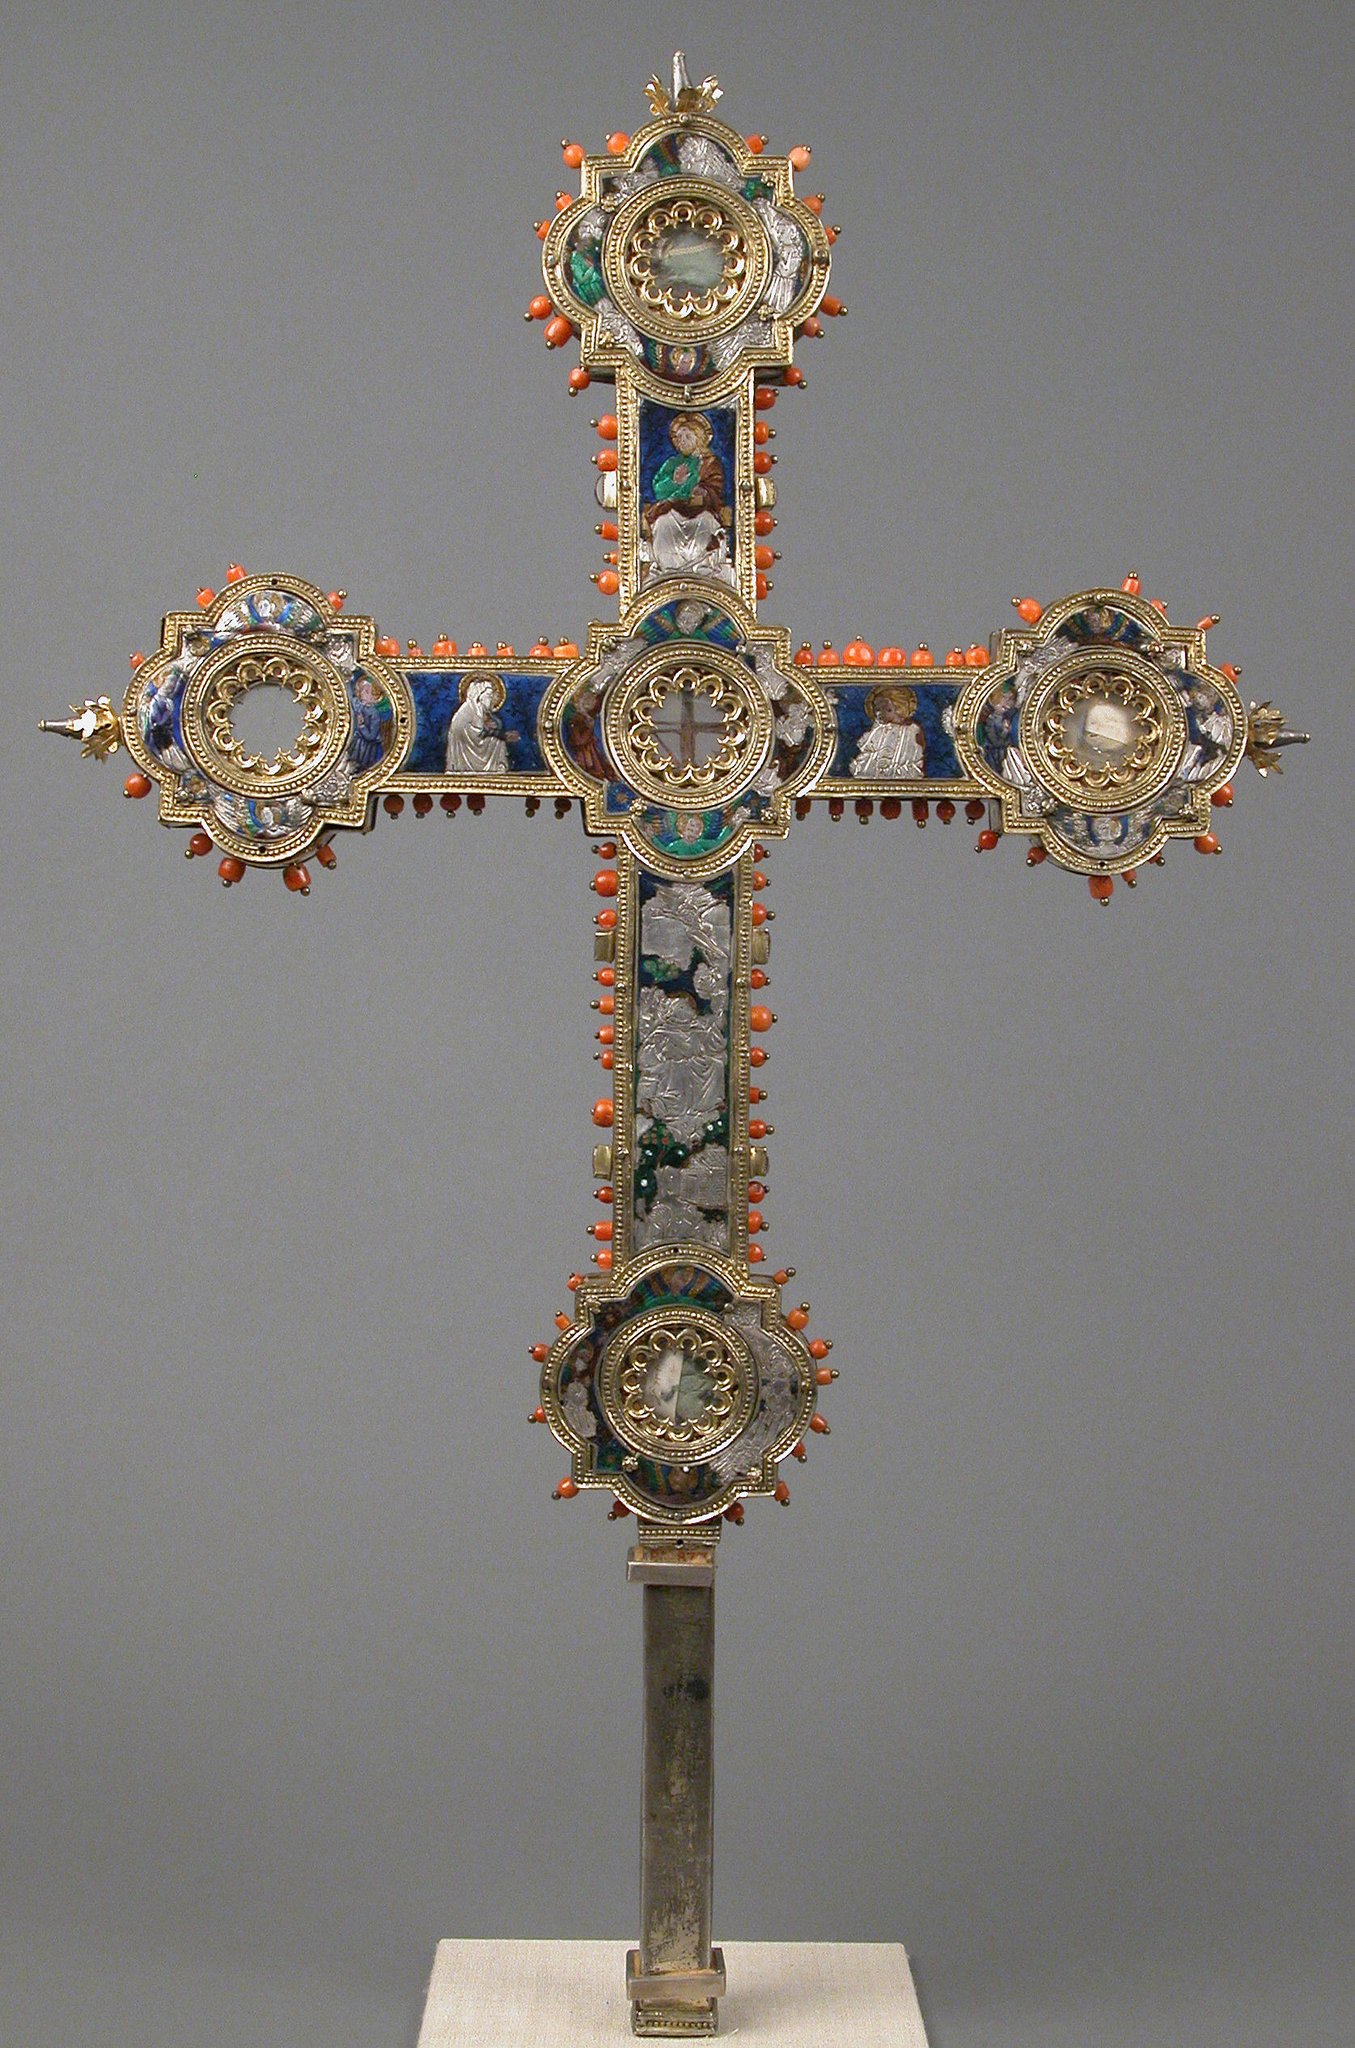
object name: reliquary cross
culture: italian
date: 1301-1400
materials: coral, enamel, glass, gold leaf, quartz, silver, silver gilt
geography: italy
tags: cross,jesus